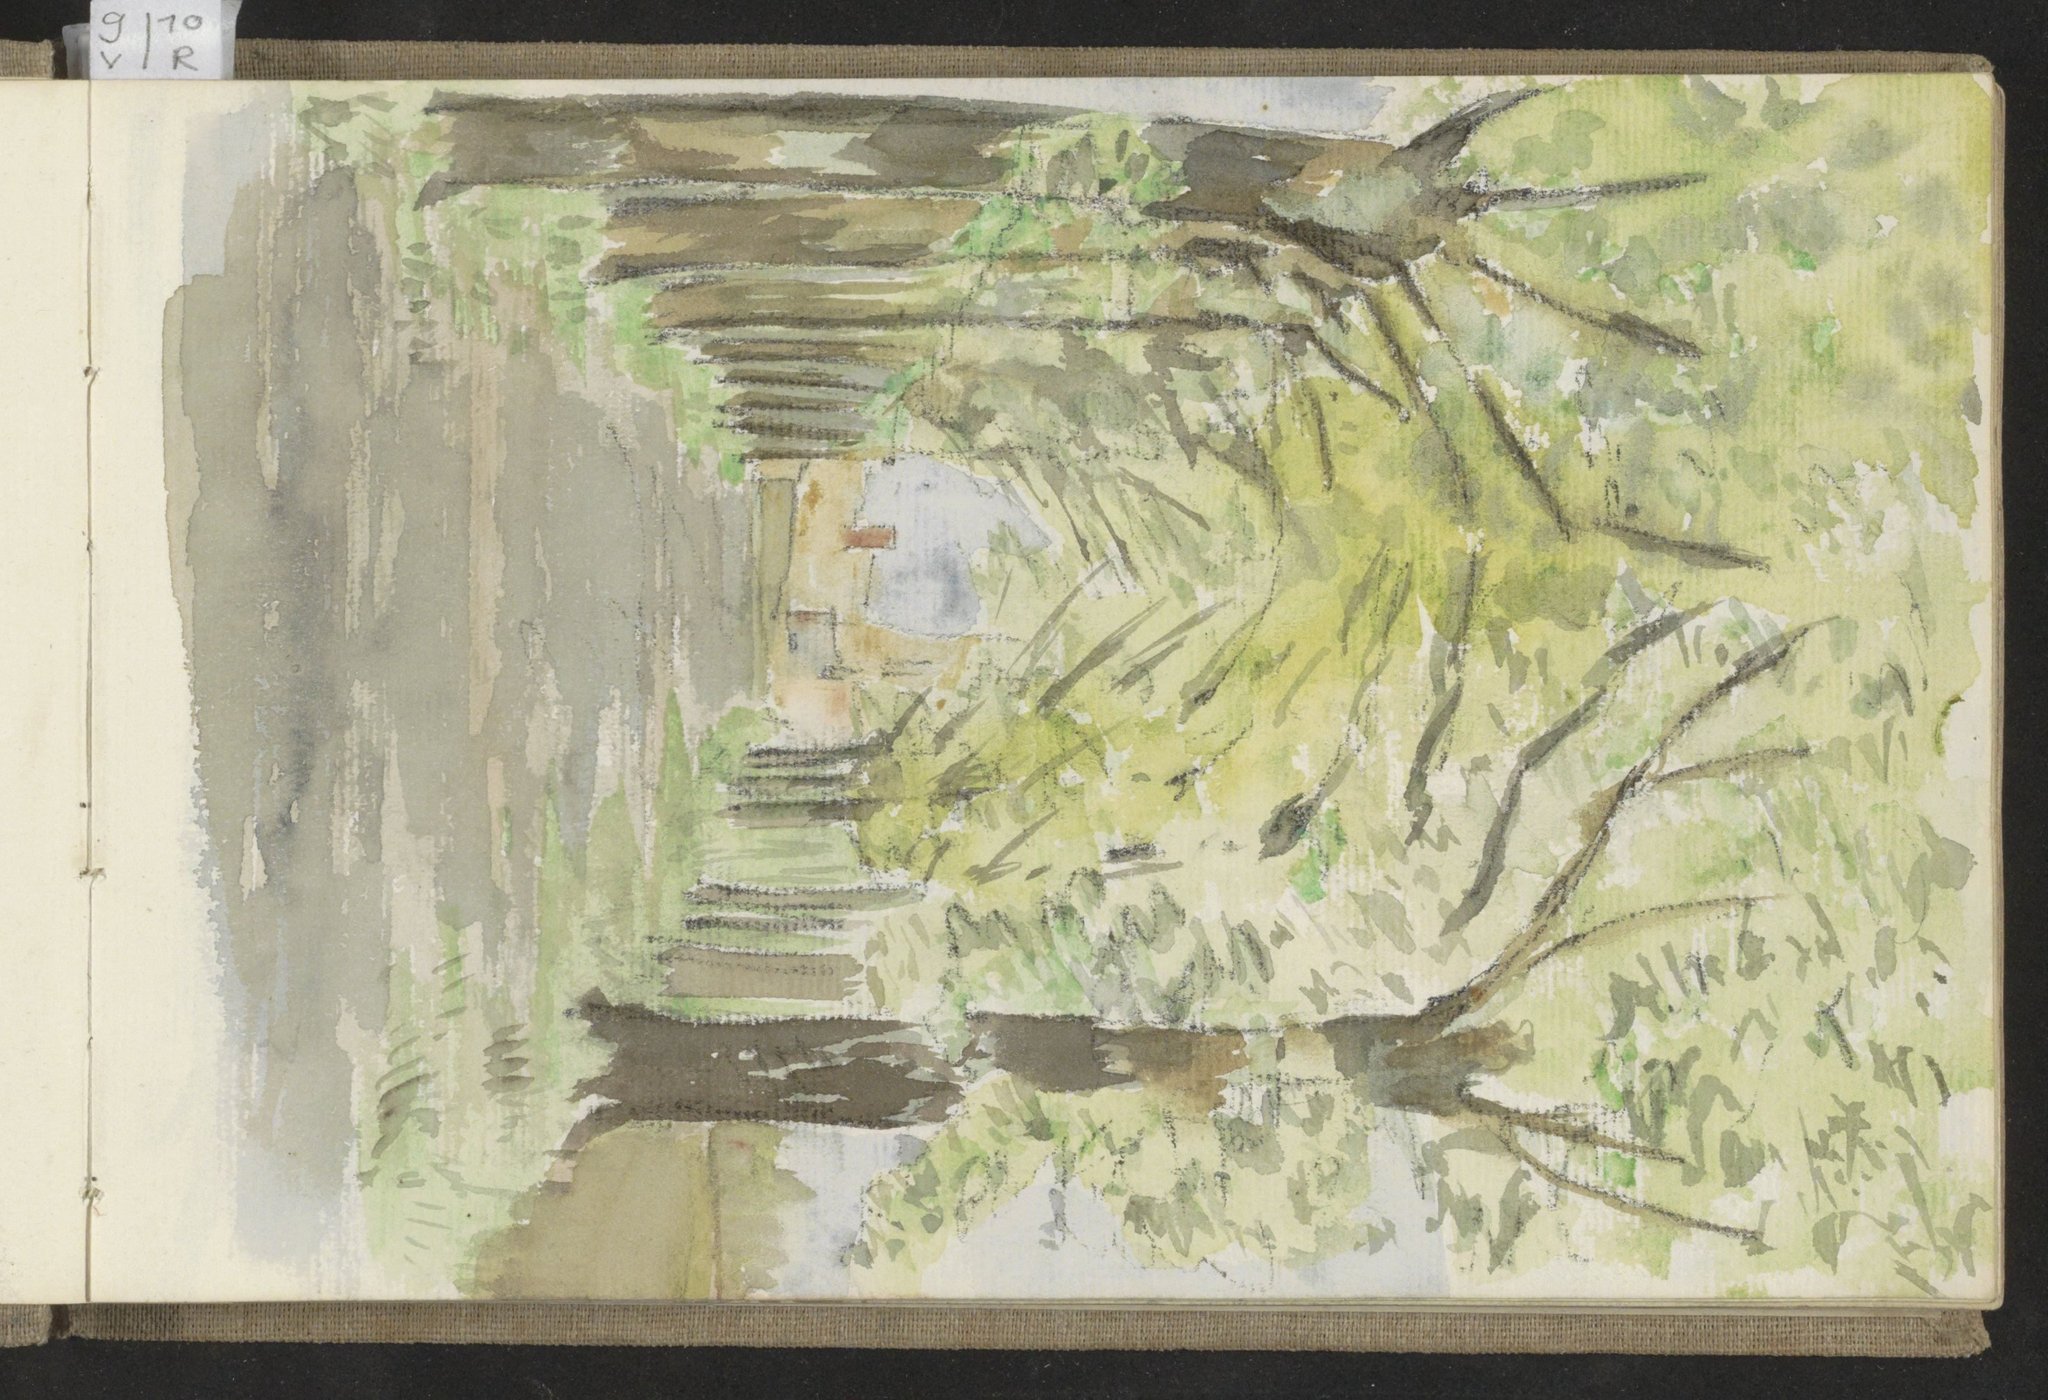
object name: sketchbook leaf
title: Bomenlaan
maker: jonkheer johannes ludovicus paulus bosch van drakestein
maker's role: draughtsman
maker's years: 1865-1929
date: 1896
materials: paper, pencil, watercolor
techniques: brush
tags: trees, road, path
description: Blad 6 recto uit een schetsboek met 58 bladen.